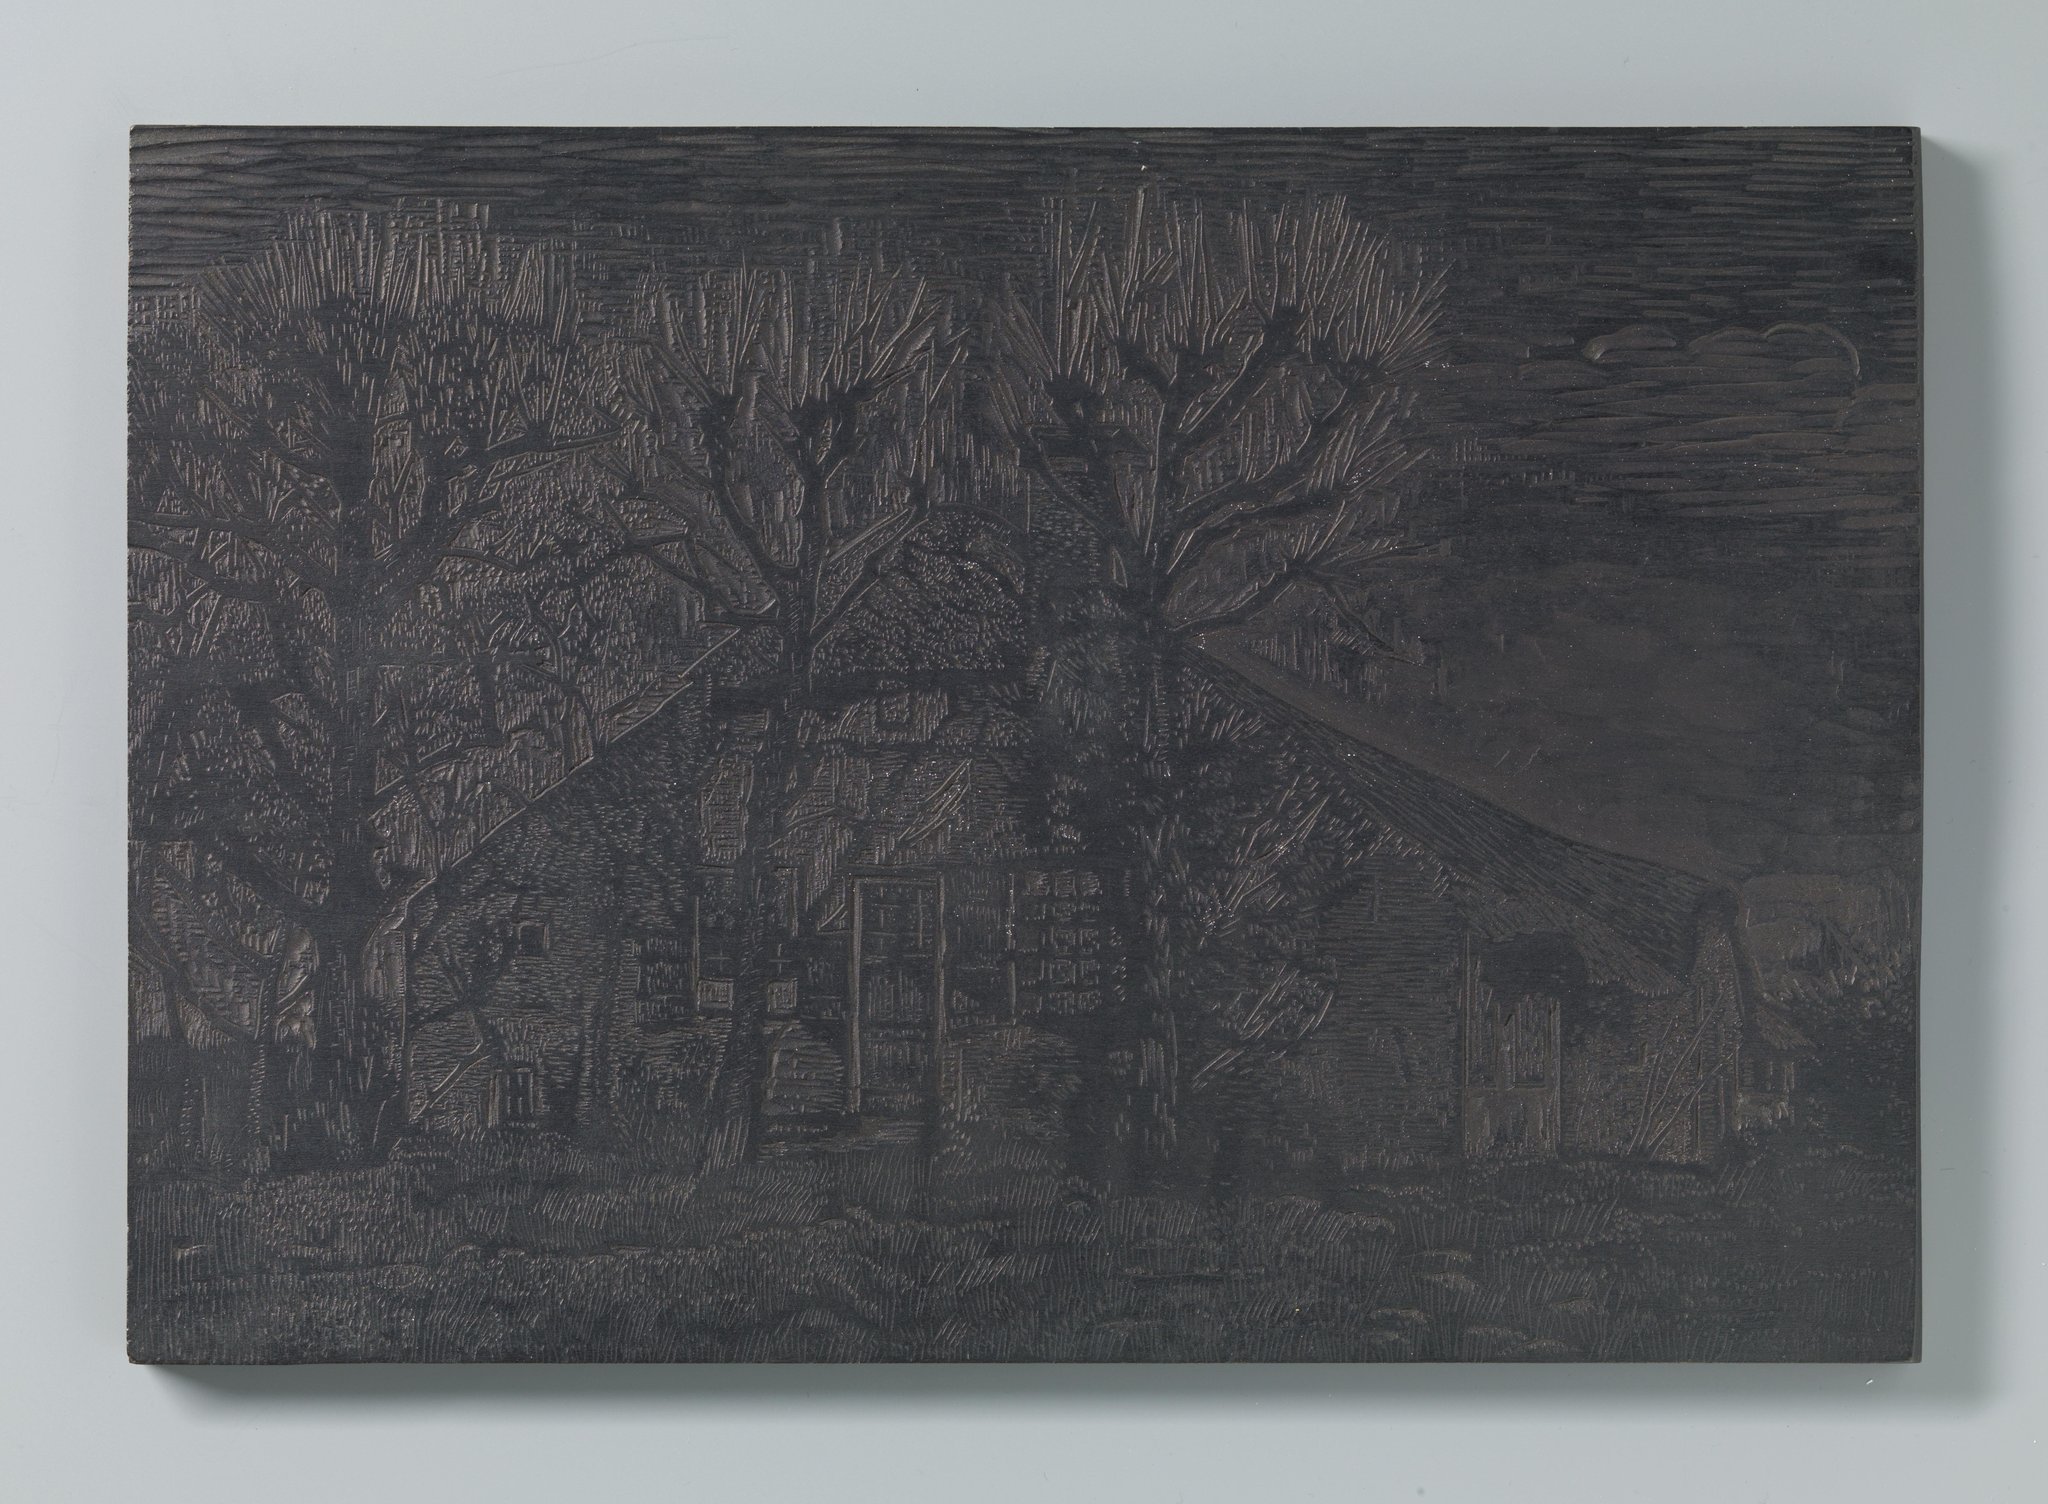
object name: wood block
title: Boerderij van Dooijewaard te Blaricum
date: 1916-1947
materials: linoleum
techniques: linocut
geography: netherlands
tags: farm or solitary house in landscape